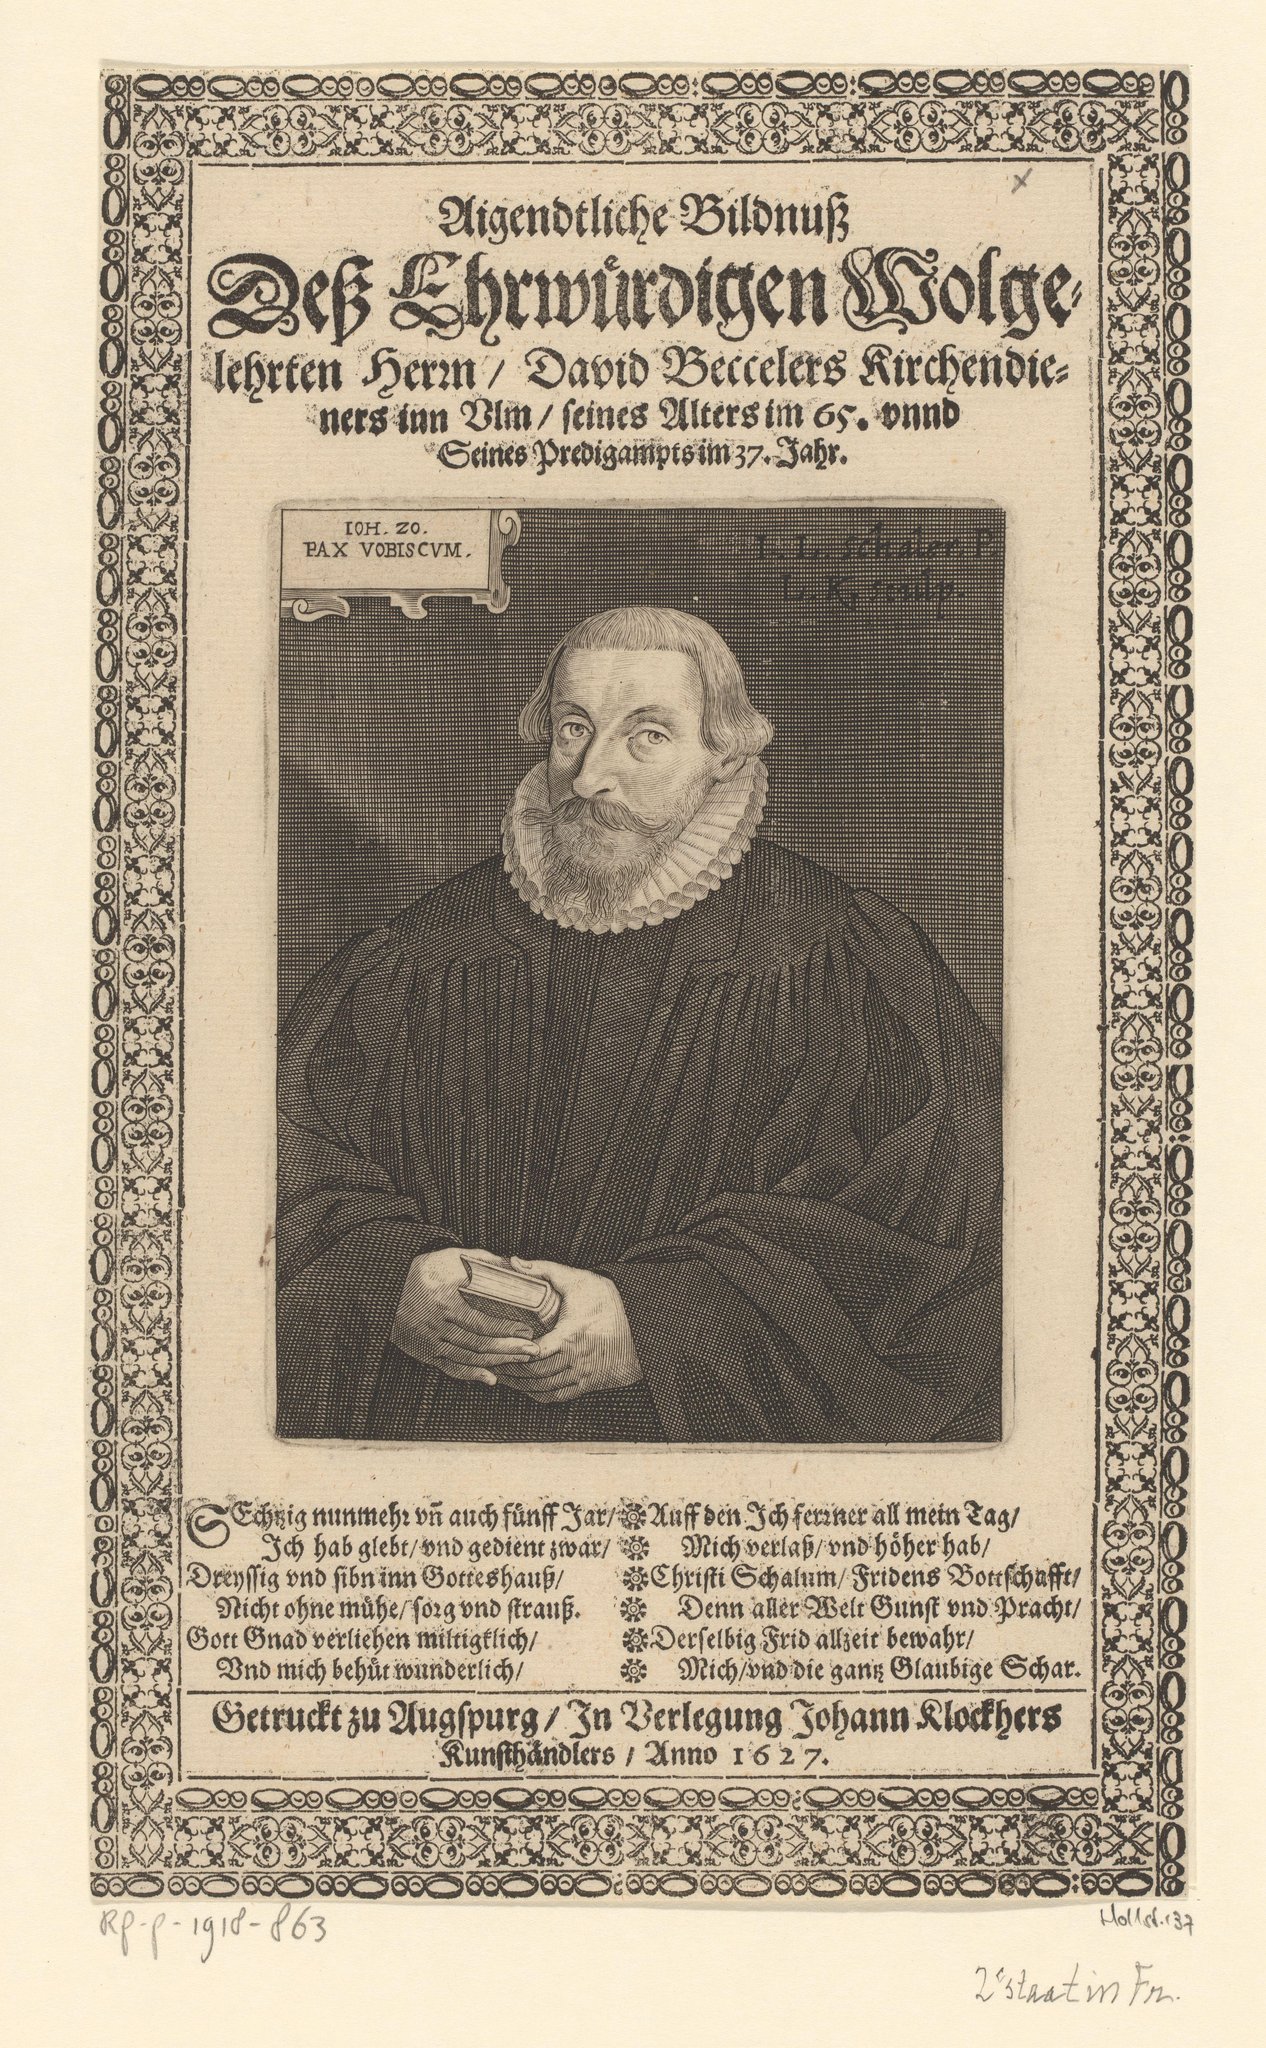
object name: print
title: Portret van David Beckeler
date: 1627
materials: paper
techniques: engraving, letterpress printing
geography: augsburg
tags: theologian, historical persons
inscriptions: collector's mark: Lugt 2233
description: Tekst in het Latijn in boekdruk op het blad binnen een omkadering van fleurons.